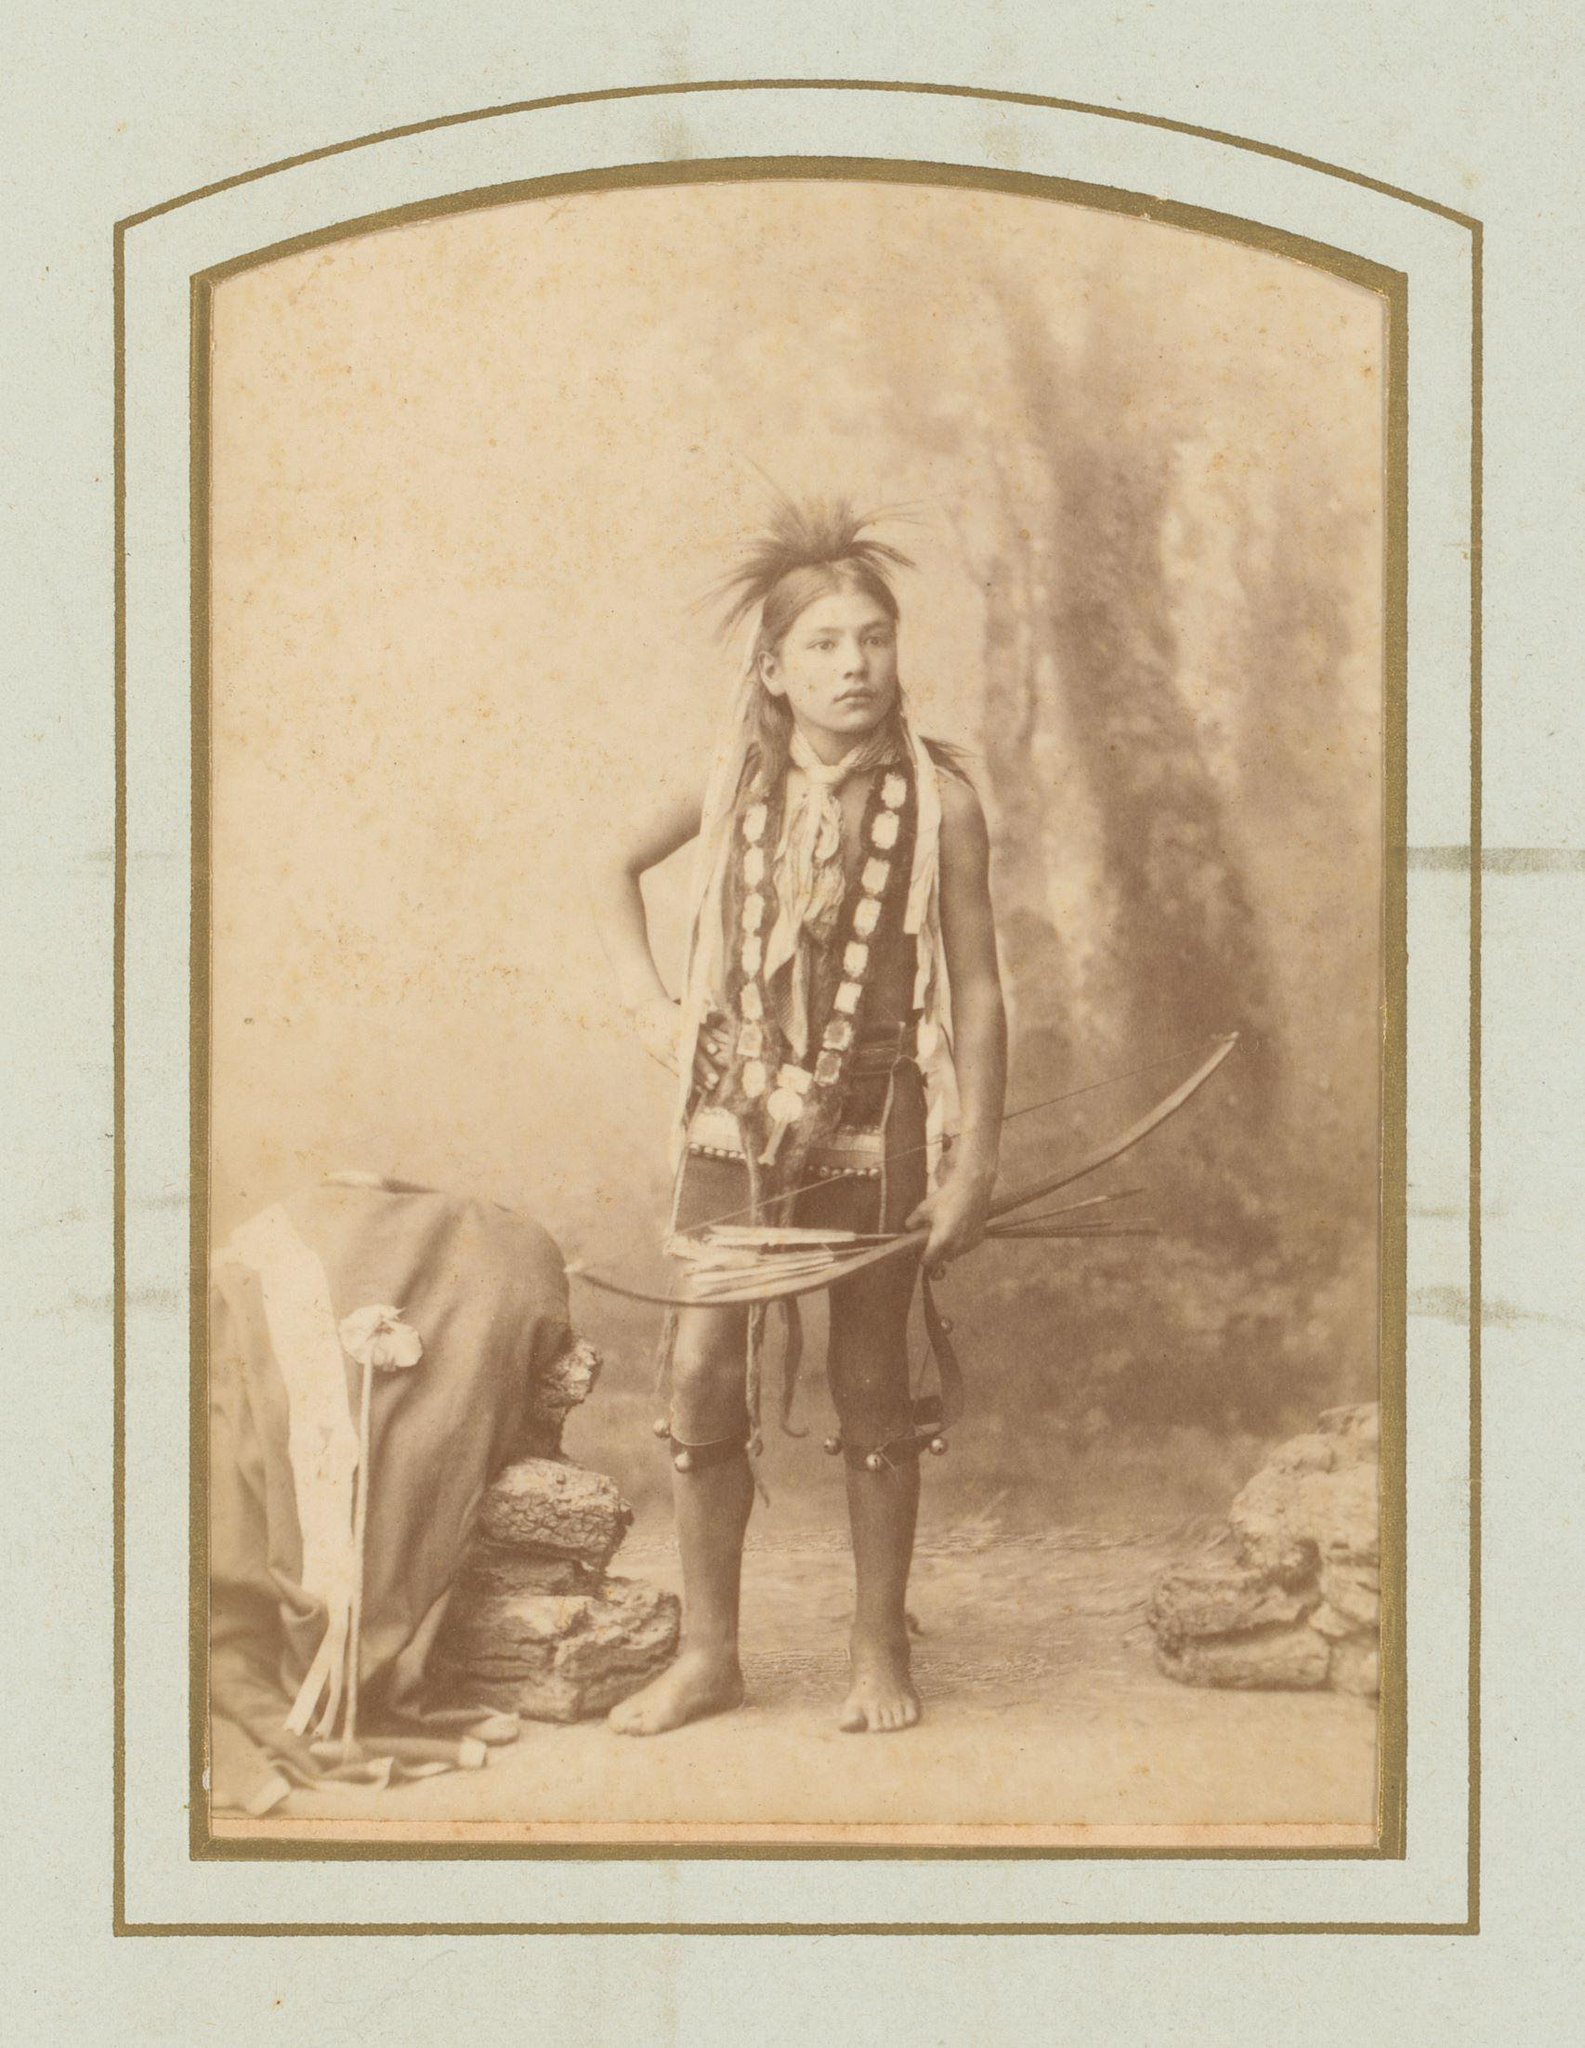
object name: cabinet photograph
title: Portret van een jongen met pijl en boog in de hand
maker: eugène pirou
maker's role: fotograaf, fotostudio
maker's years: 1841-1909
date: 1864-1904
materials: cardboard, photographic support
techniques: albumen print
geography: paris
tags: archer's weapons: bow and arrow, boy (child between toddler and youth), historical persons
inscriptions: inscription: ‘Photographie/ (...)/ Salons'/ et Ateliers/ AU REZ DE CHAUSSÉE/ ET AU 1ER ETAGE/ Eug. Pirou/ 23, Rue Royale/ Paris/ Photographie la Nuit à la Lumière Eléctrique.’